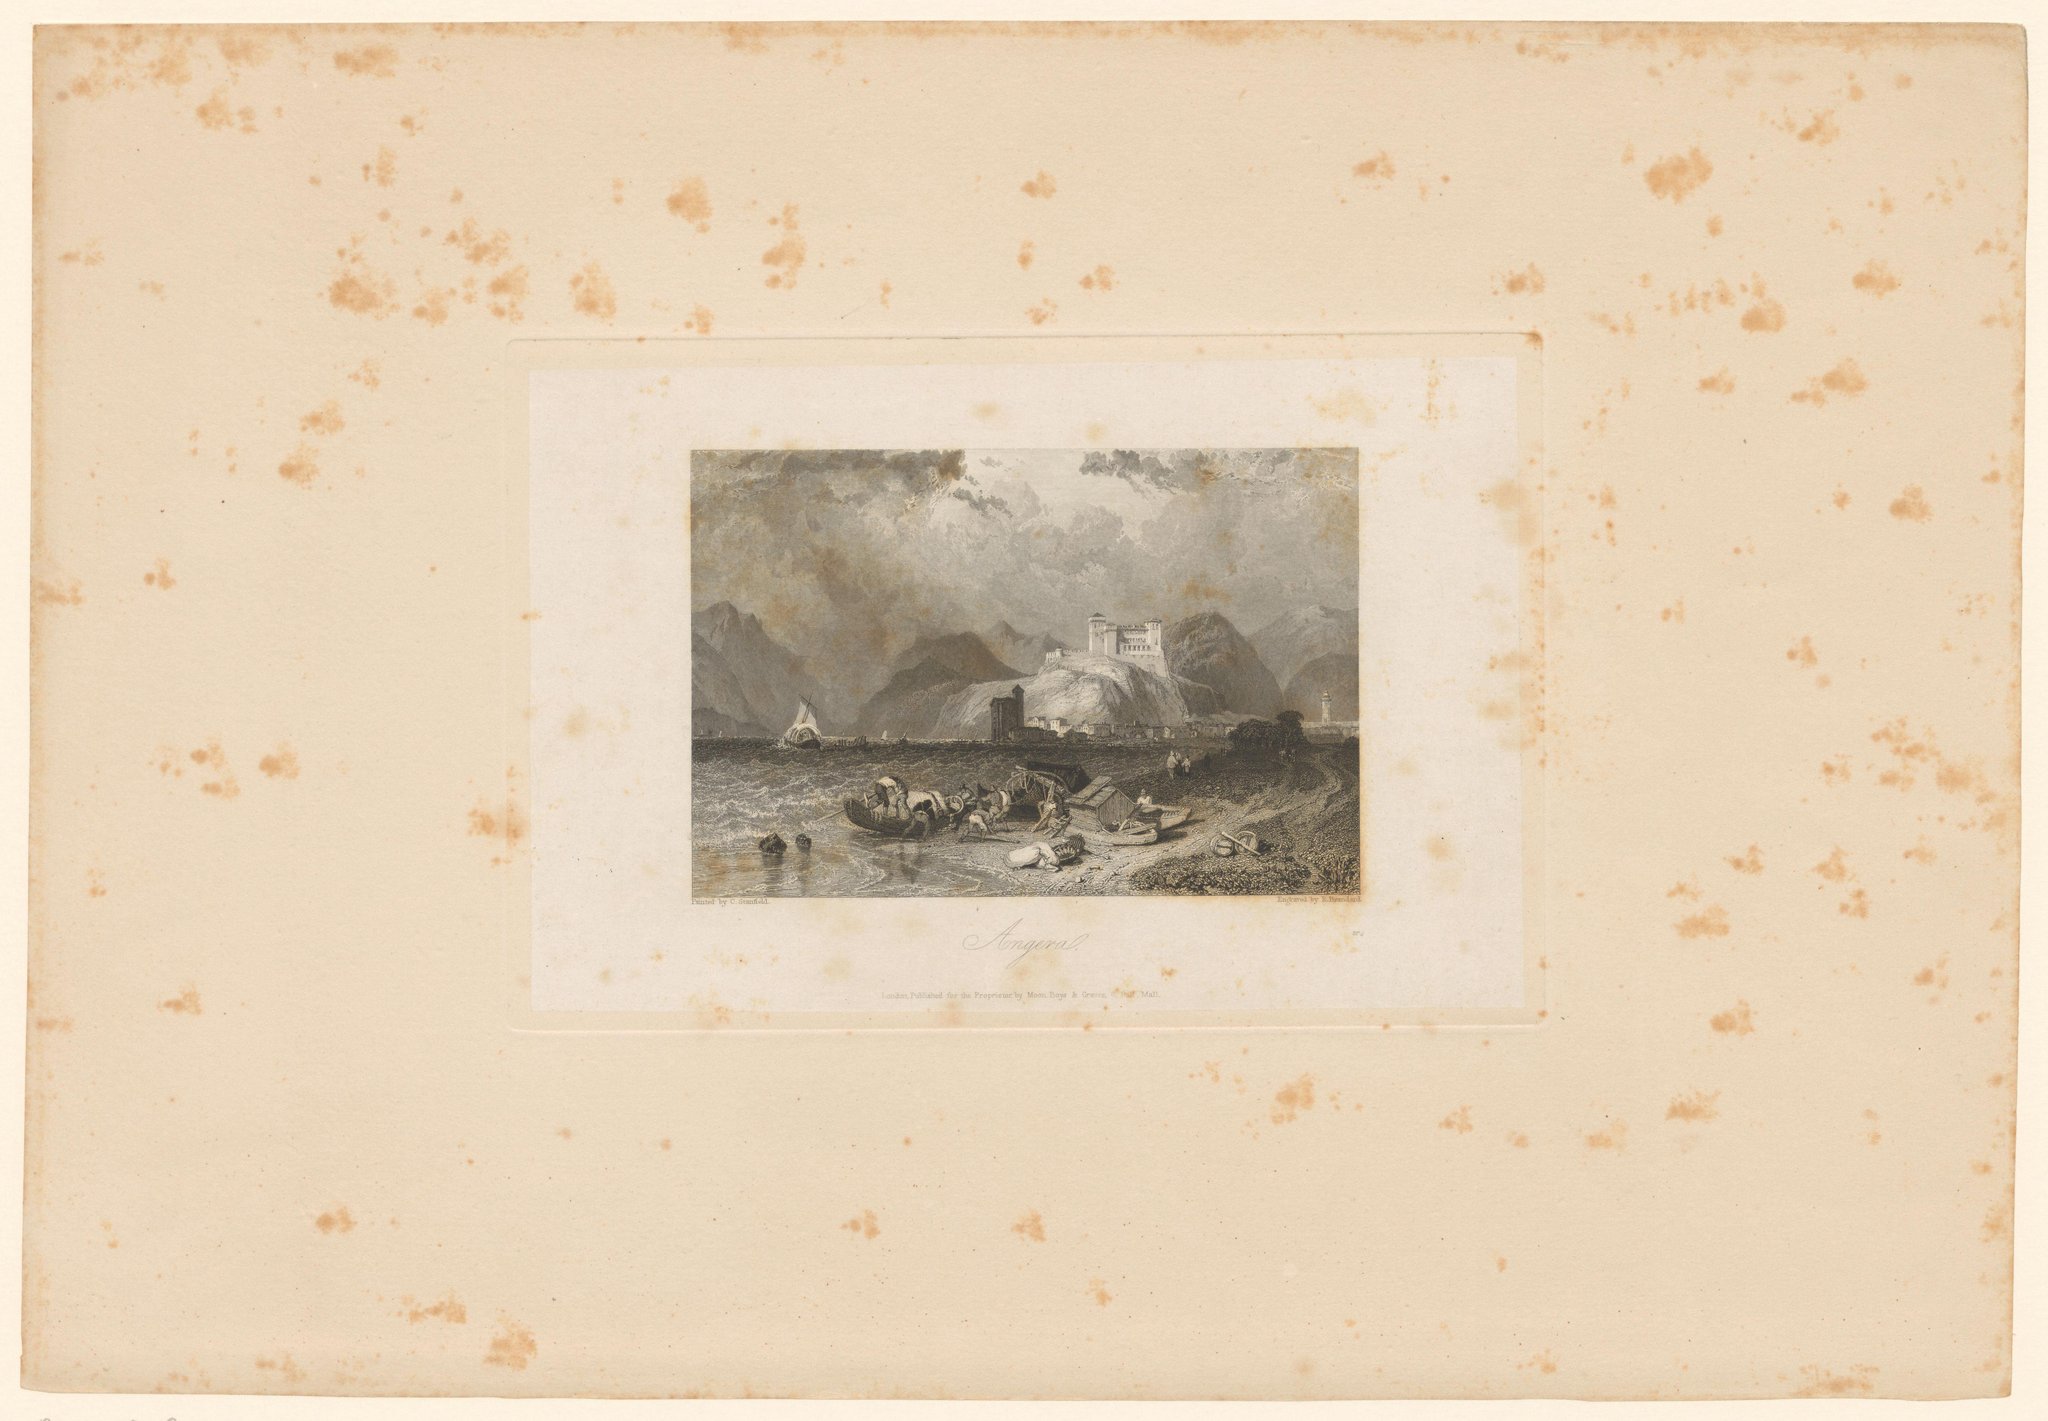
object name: print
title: Angera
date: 1832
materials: paper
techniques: engraving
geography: london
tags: landscape with tower or castle, lake (+ landscape with figures, staffage)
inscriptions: collector's mark: Lugt 2228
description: Huidige staat van prent mogelijk gebruikt in: Heath's Picturesque Annual. Travelling sketches in the north of Italy, the Tyrol and on the Rhine (...). Londen: Longman et al., 1832.